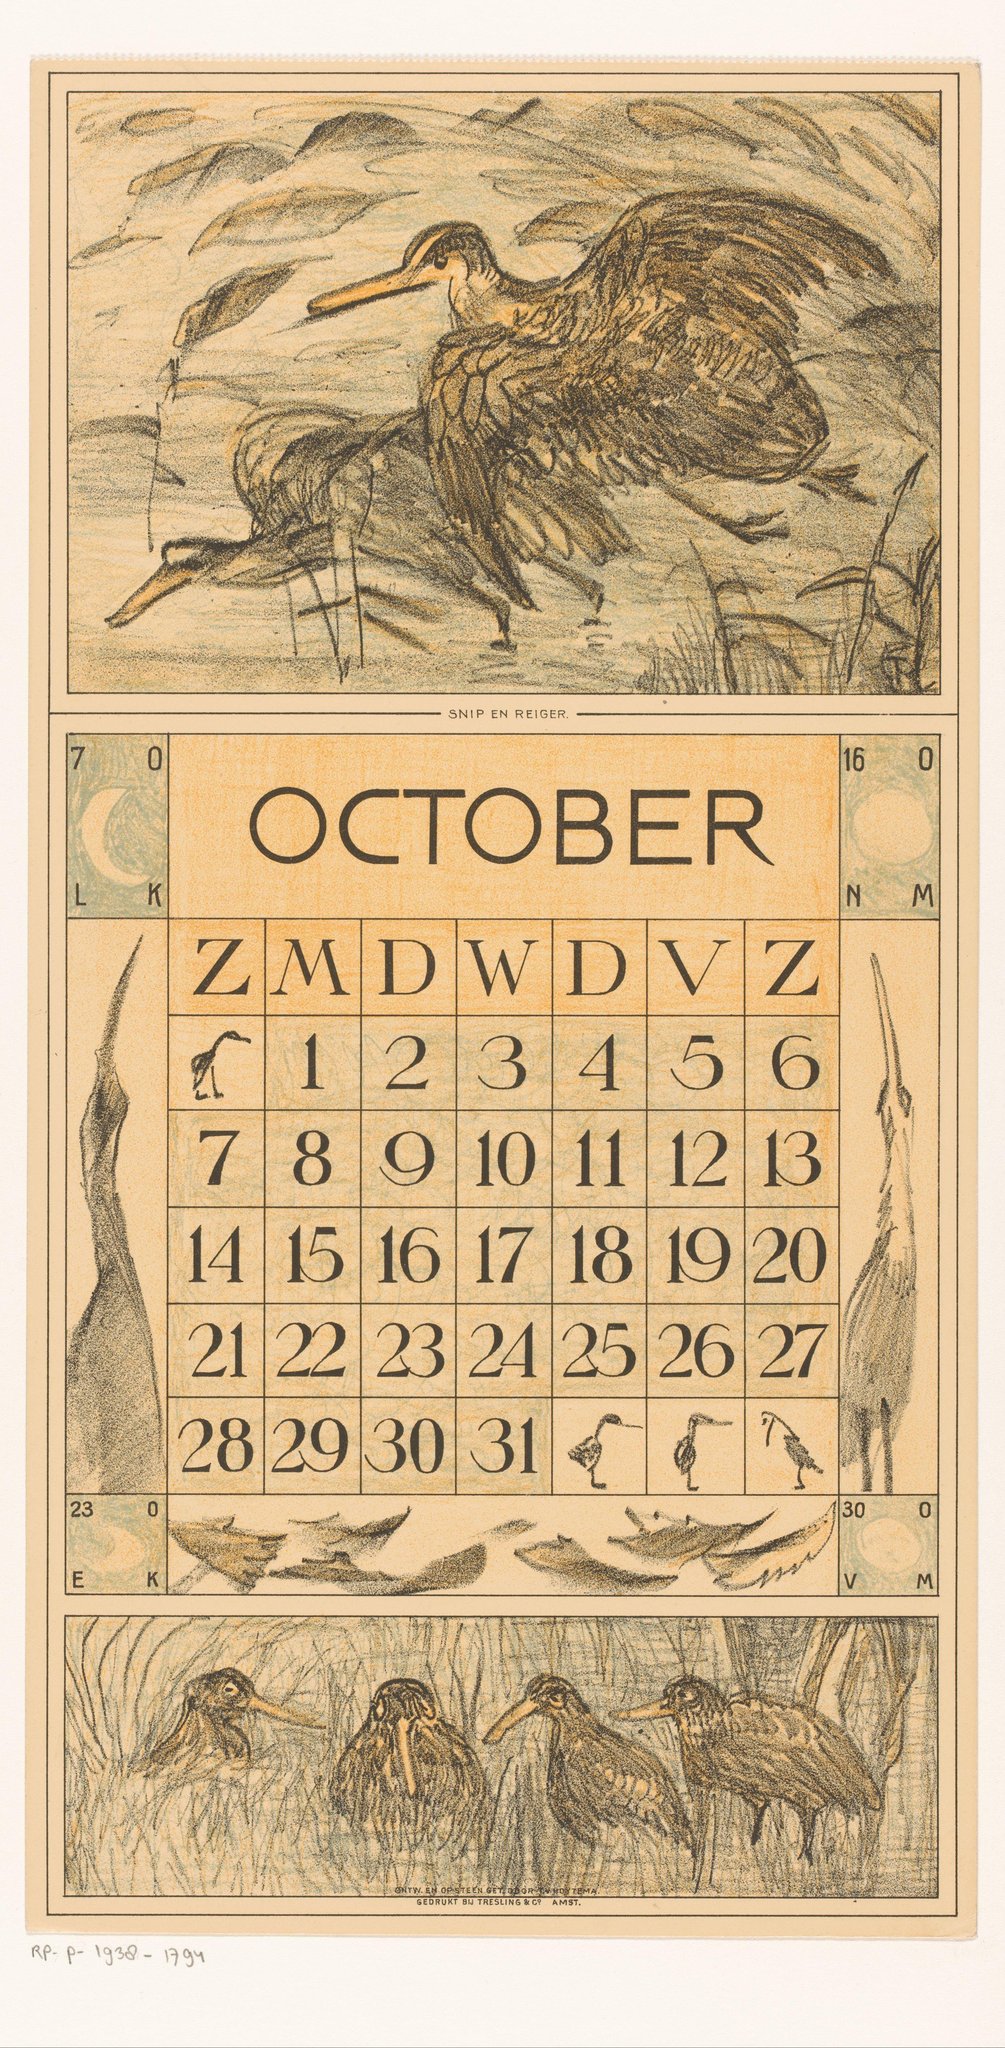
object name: calendar leaf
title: Kalenderblad oktober met snip en reiger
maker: theo van hoytema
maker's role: draughtsman, painter, print maker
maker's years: 1863-1917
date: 1916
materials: paper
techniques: lithograph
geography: amsterdam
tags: shore-birds and wading-birds: heron, lunar year, shore-birds and wading-birds: snipe, october ~ other concepts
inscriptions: collector's mark: Lugt 2228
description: Bovenin vliegen een snip en een reiger. Onderin vier snippen. In de hoeken de standen van de maan op vier dagen. Bovenaan het blad een scheurlijn.